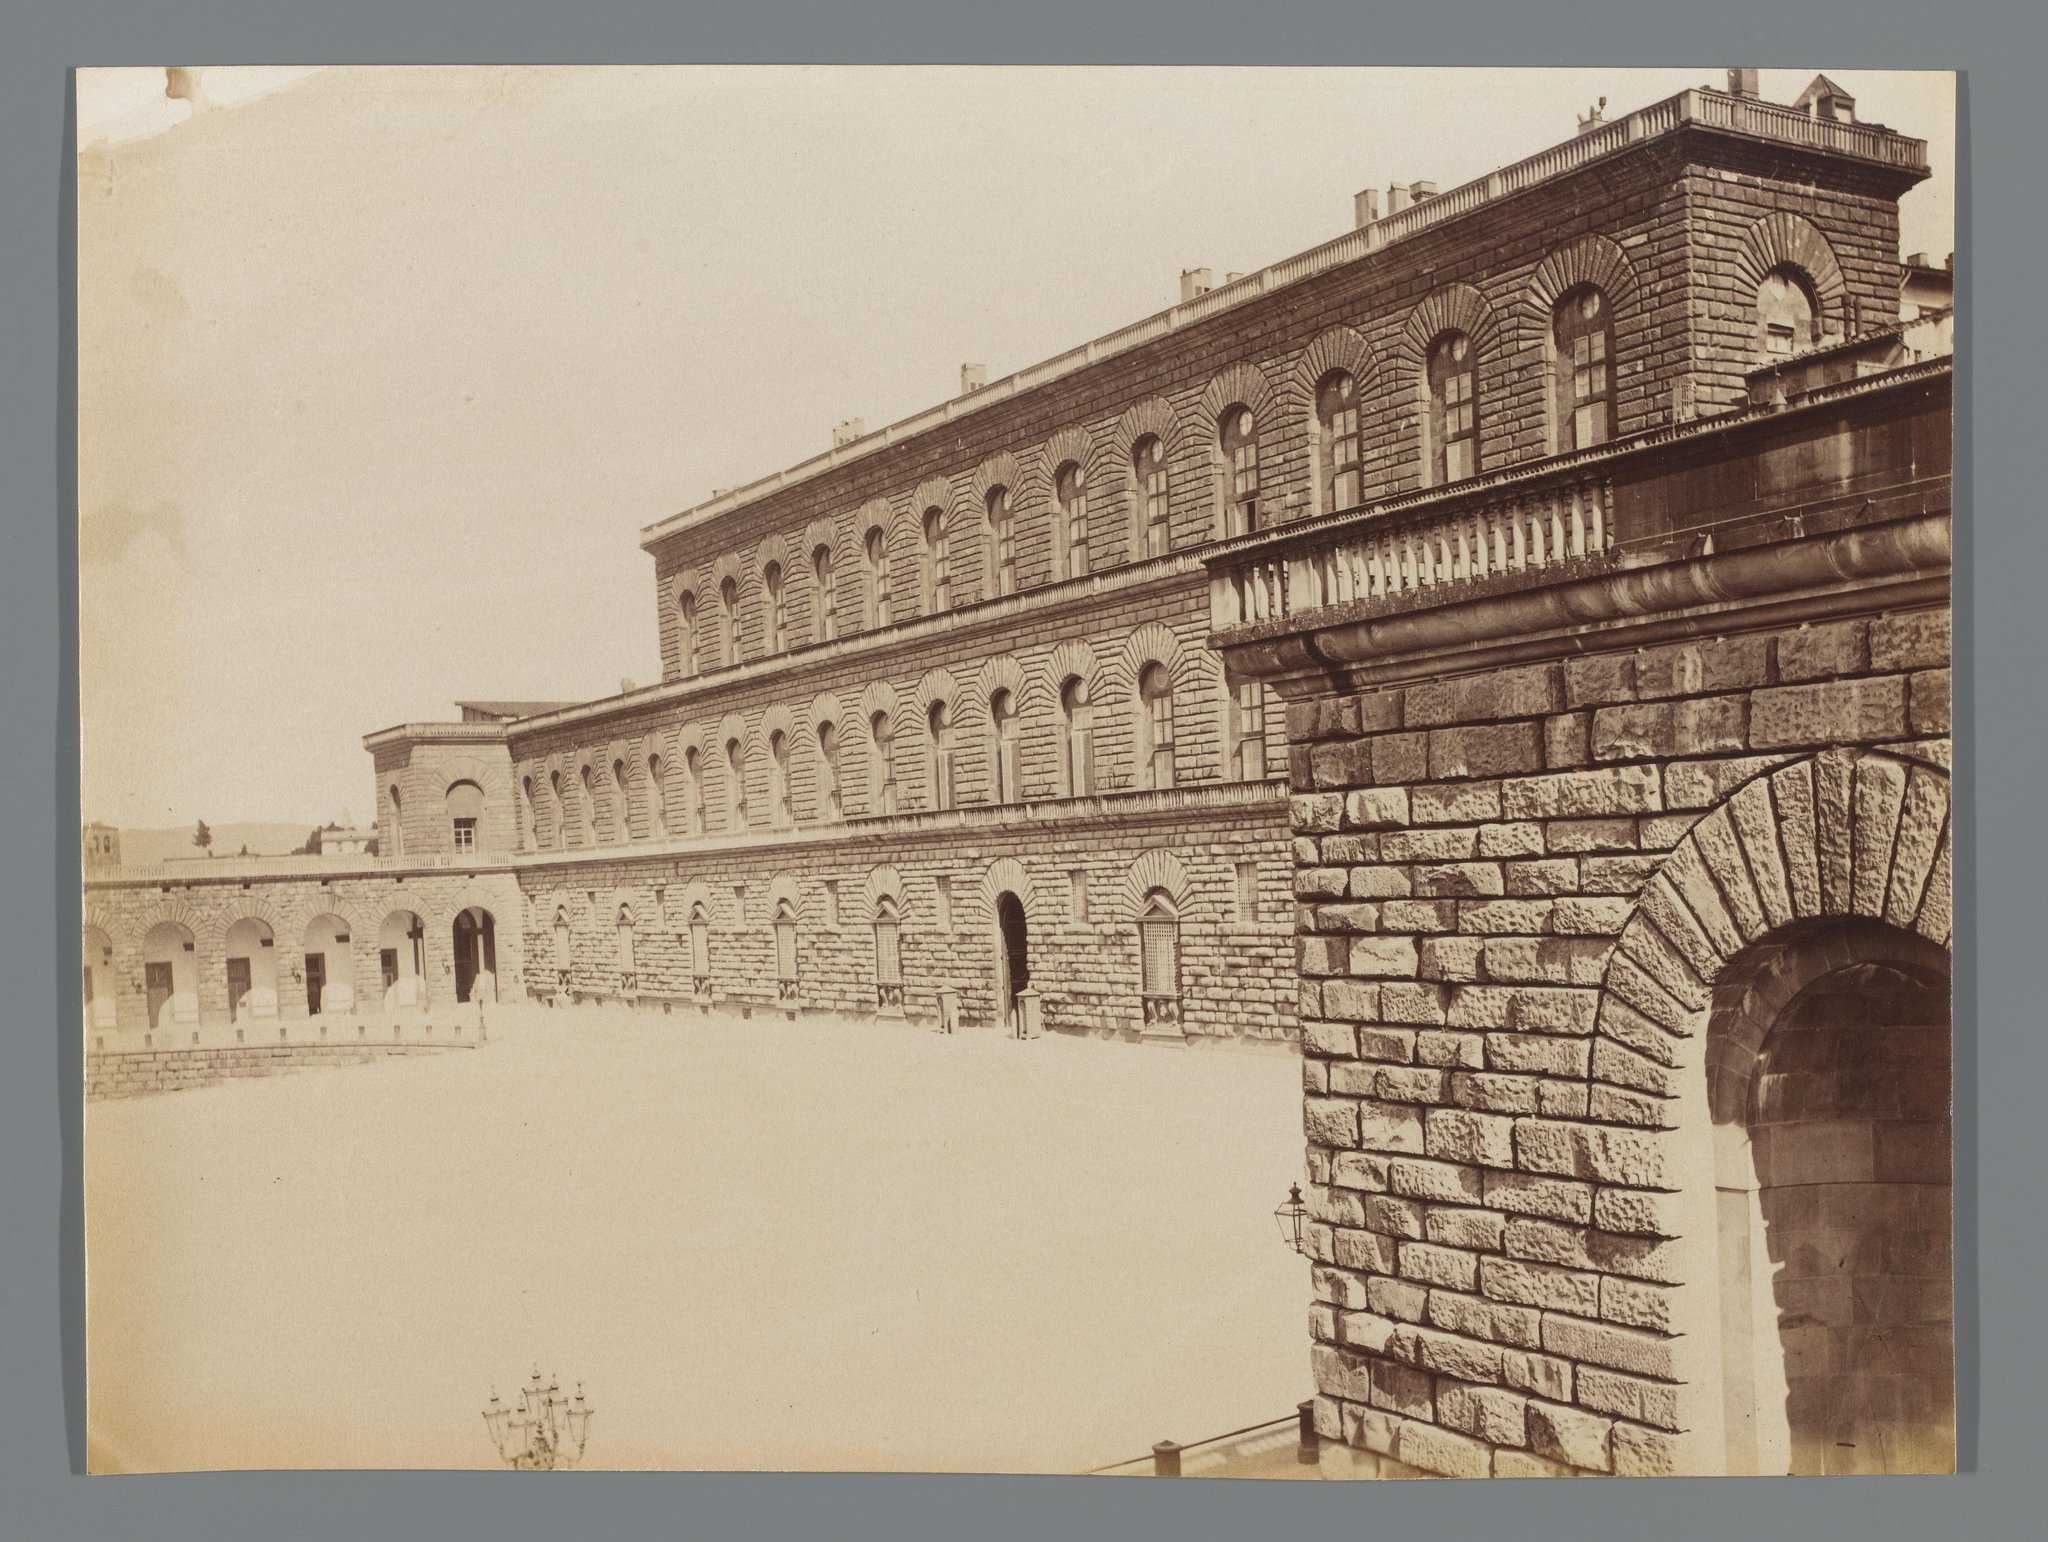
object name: photograph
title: Gezicht op de voorzijde van het Palazzo Pitti in Florence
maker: Anonymous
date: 1851-1900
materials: paper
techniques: albumen print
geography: florence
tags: exterior ~ representation of a building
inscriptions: collector's mark: ‘VOSMAER’